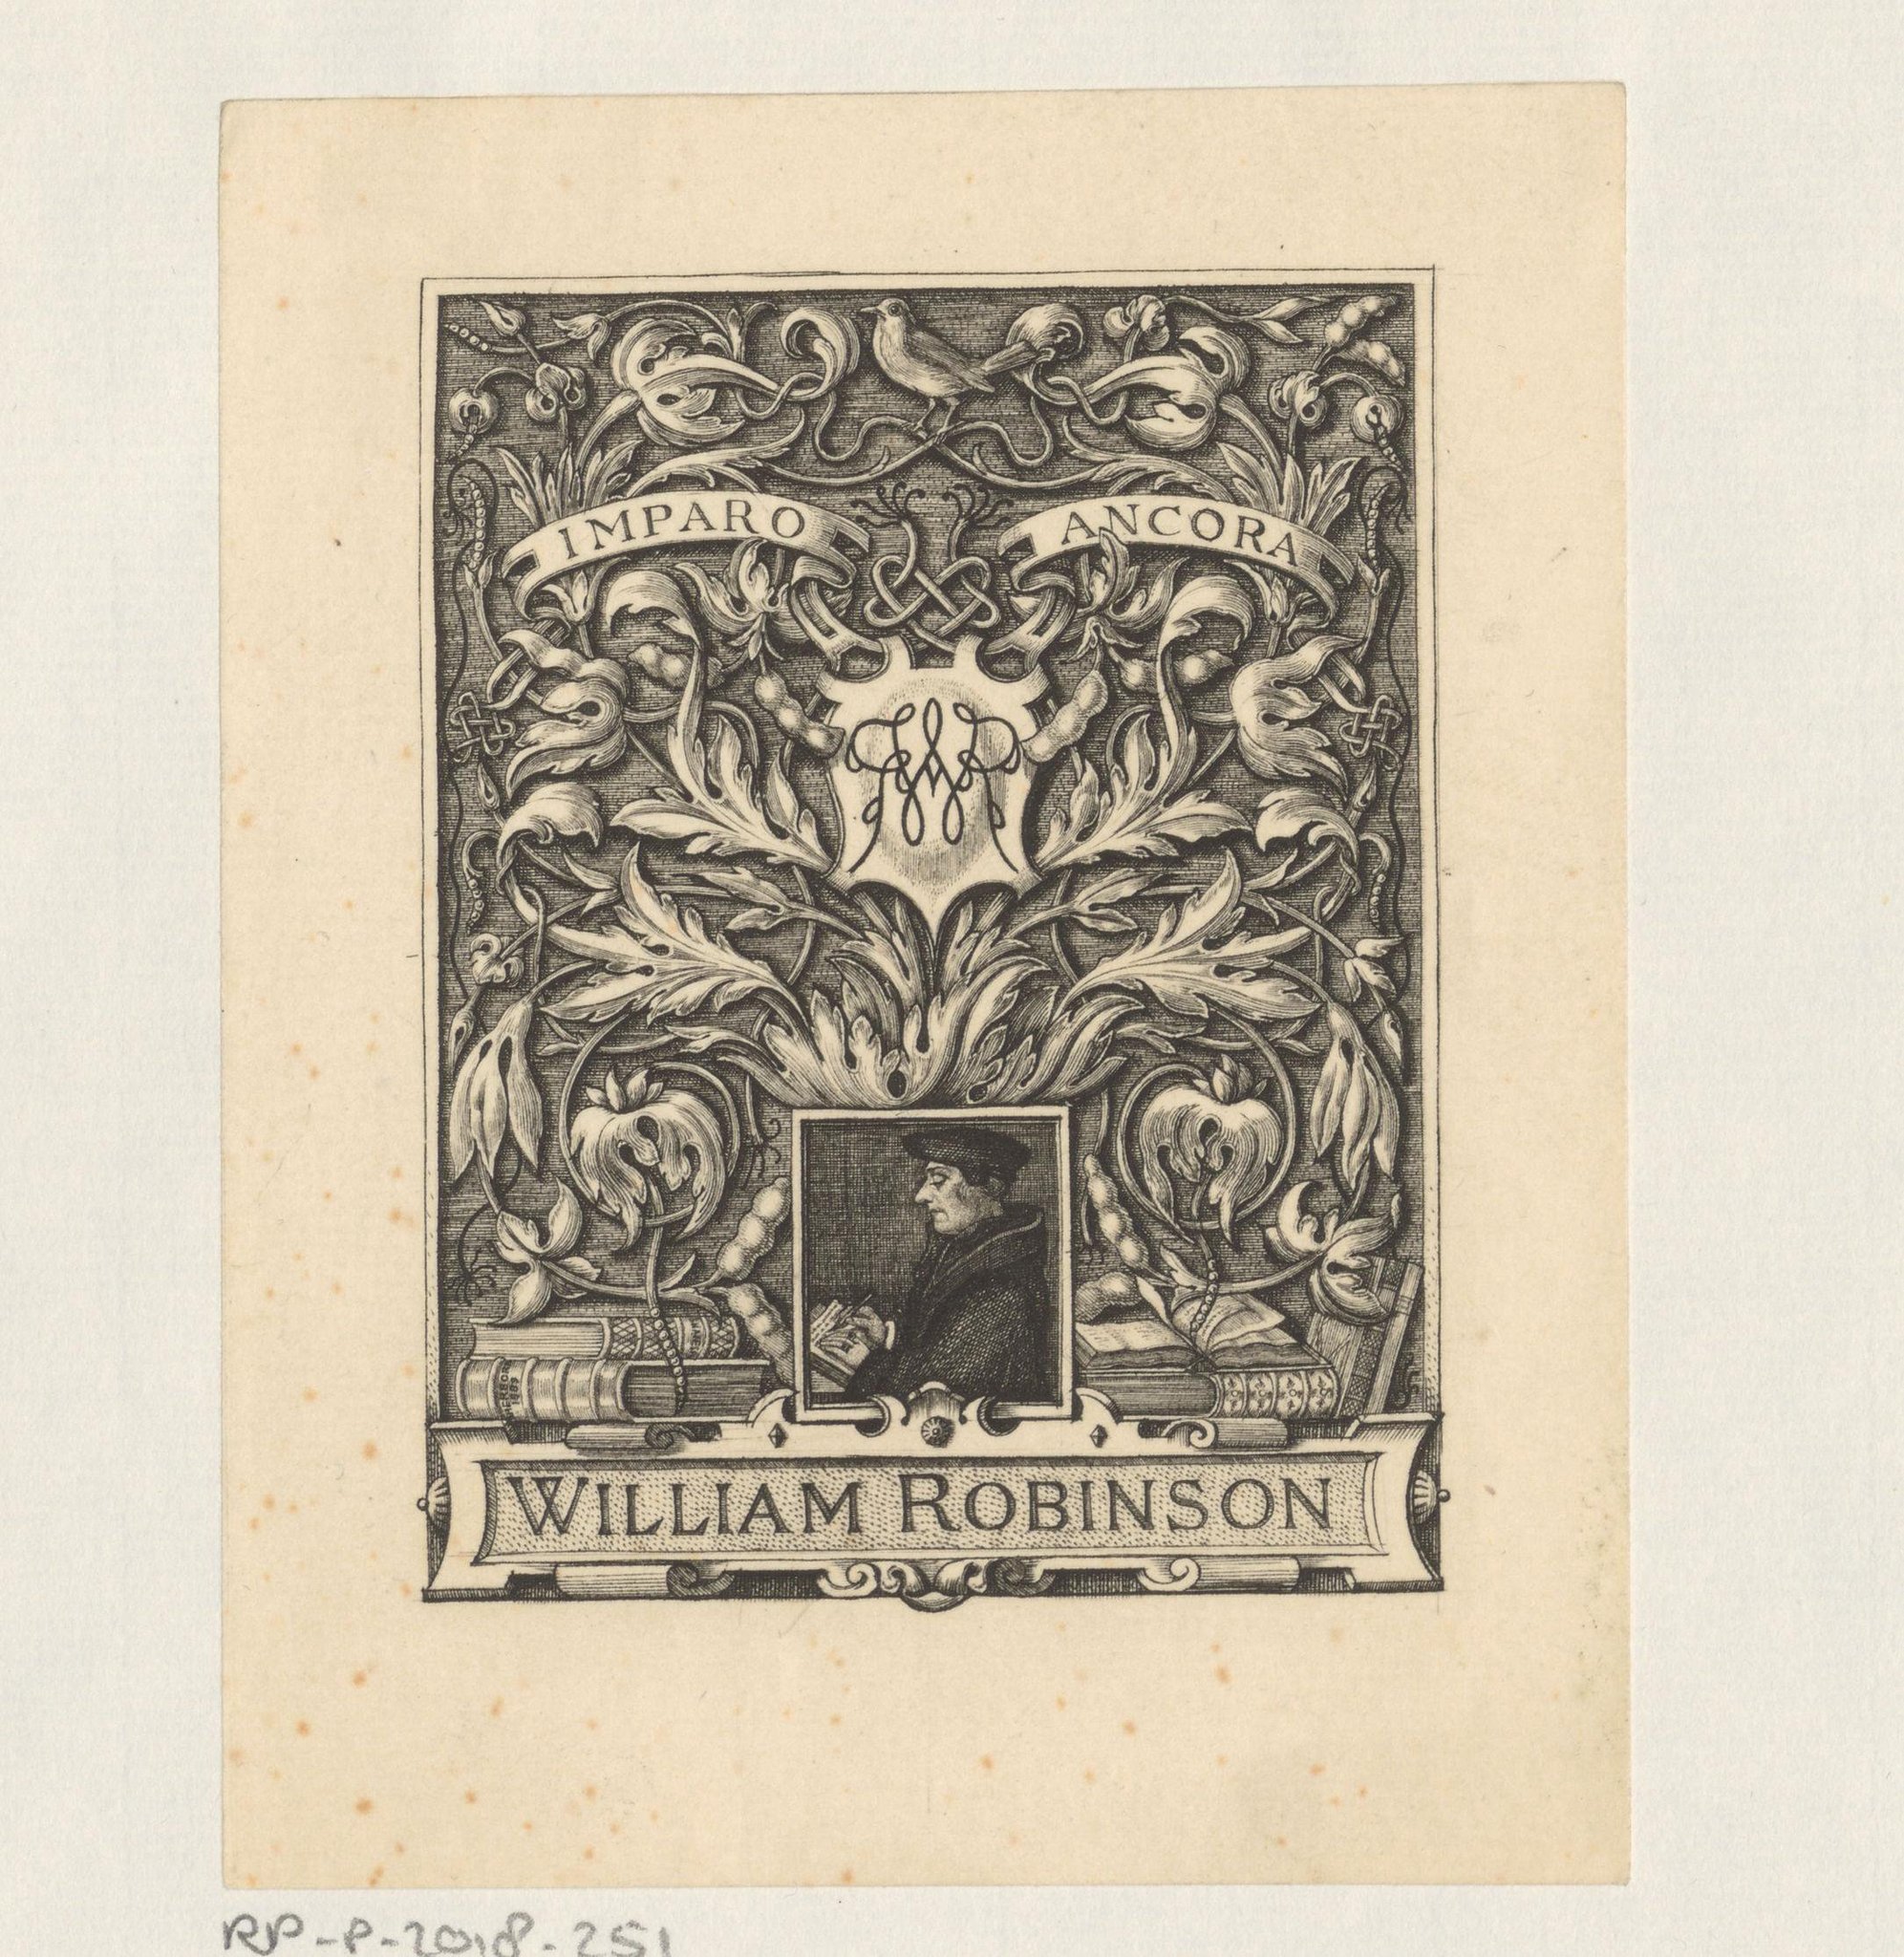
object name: bookplate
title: Ex libris van William Robinson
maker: charles william sherborn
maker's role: print maker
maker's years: 1831-1912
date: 1889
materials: paper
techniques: engraving, etching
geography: england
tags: sitting figure, flowers ~ ornament - aa - stylized, birds, historical costume, book, writing and letters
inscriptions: date